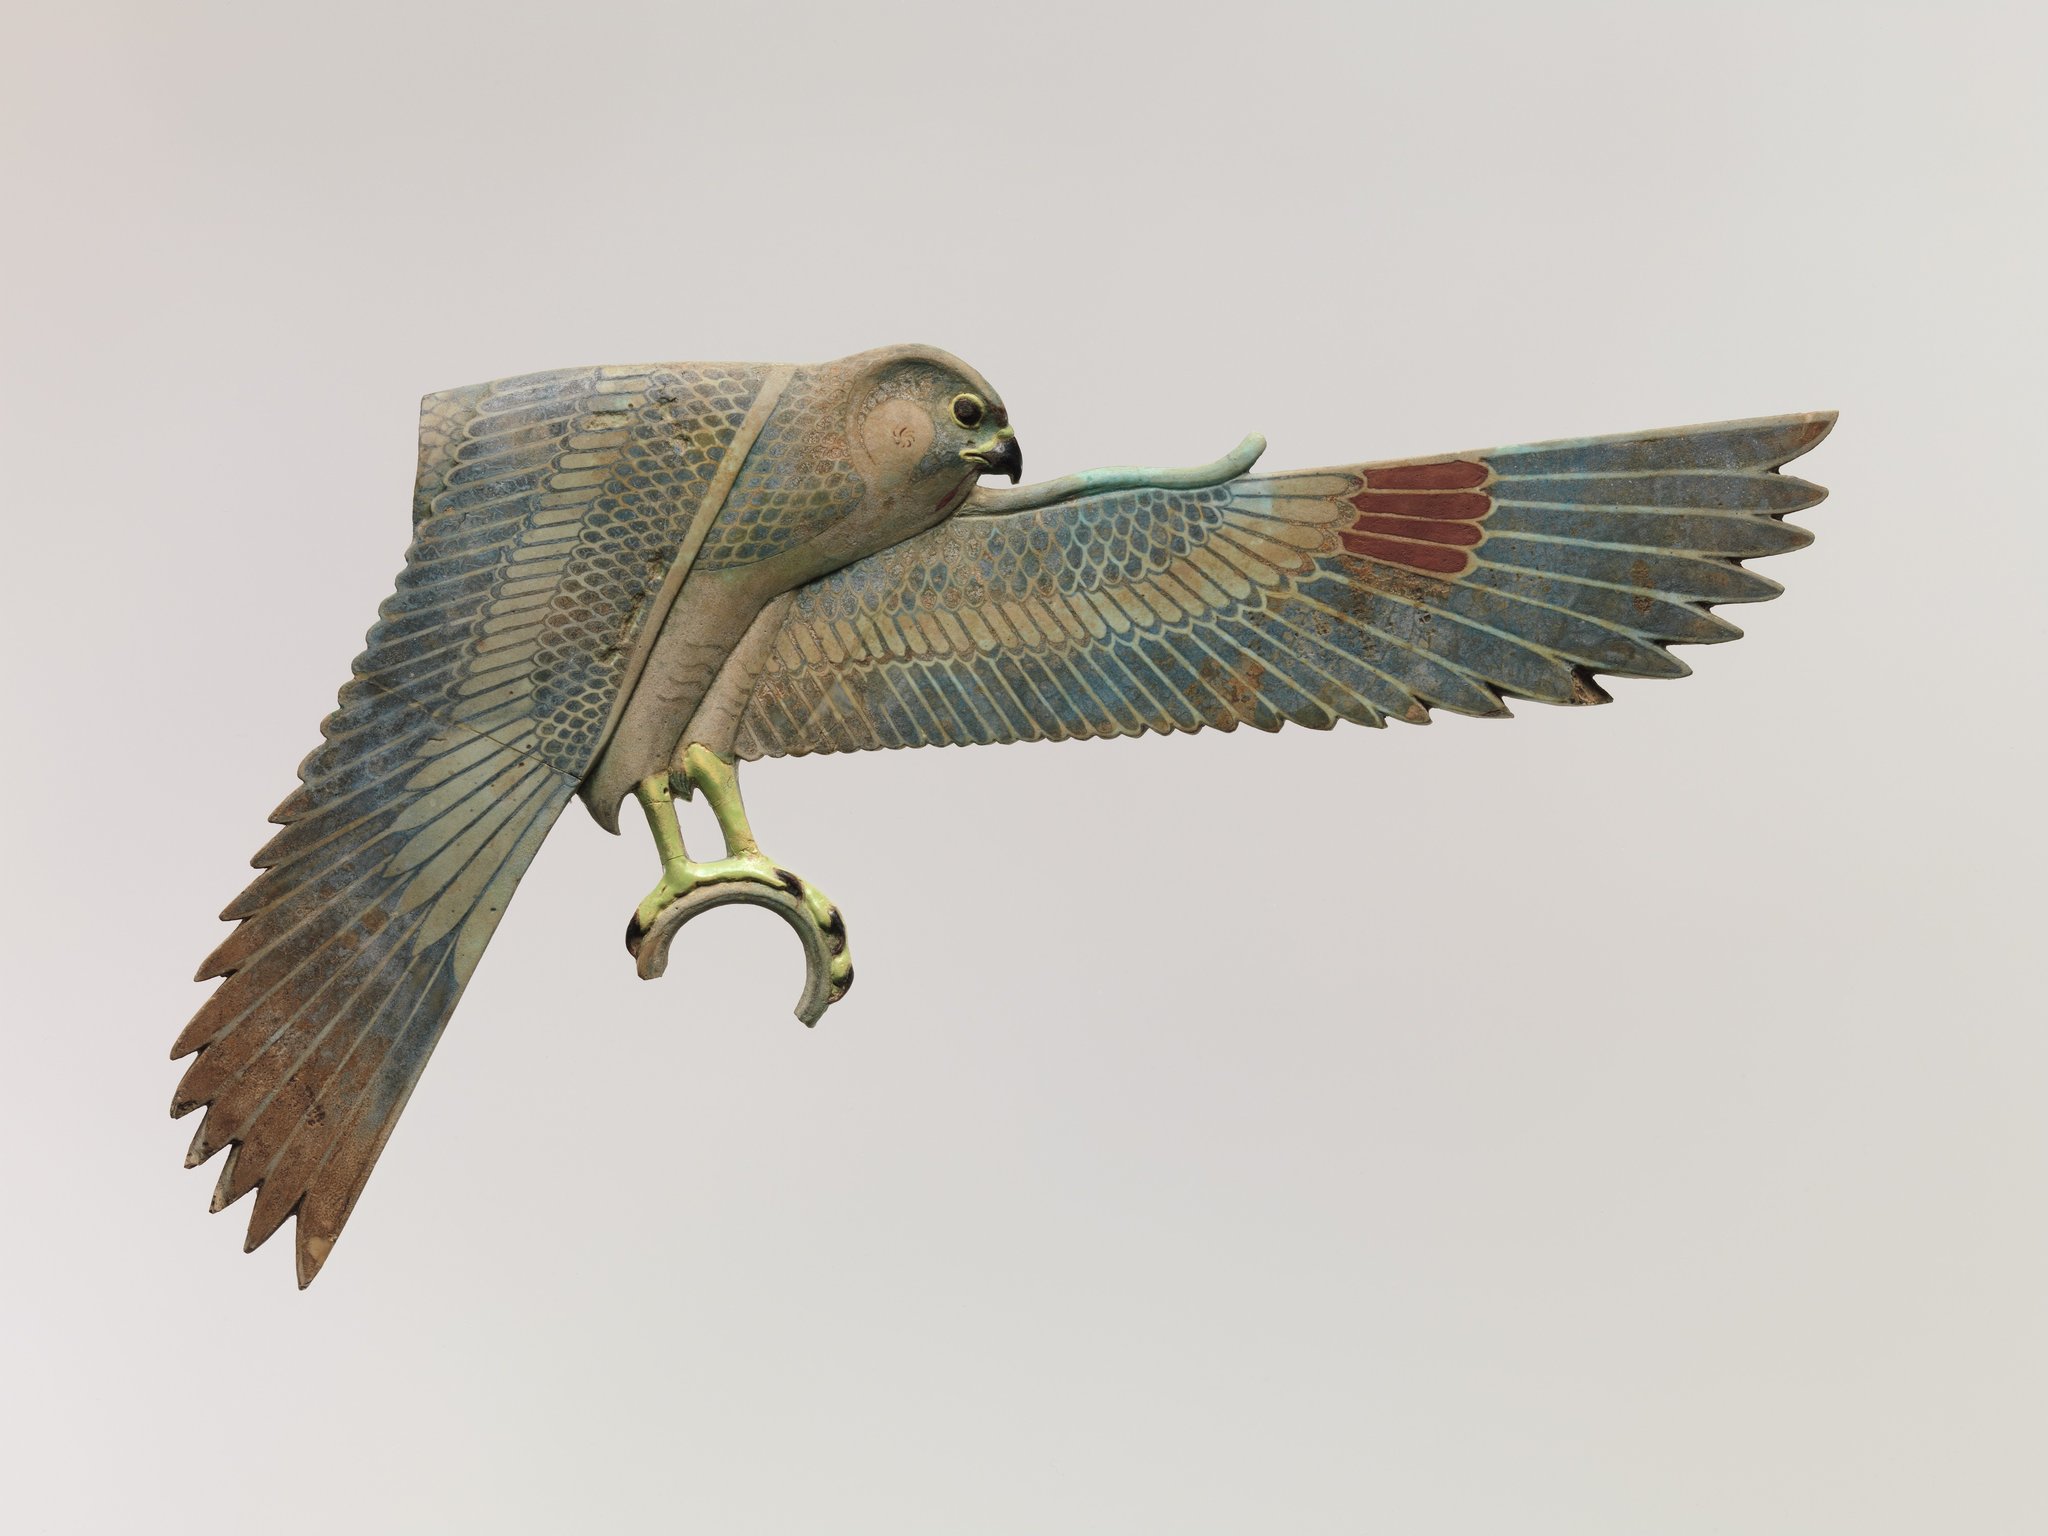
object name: inlay, falcon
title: Inlay Depicting a Falcon with Spread Wings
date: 400-301 BCE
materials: faience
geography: middle egypt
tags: falcons